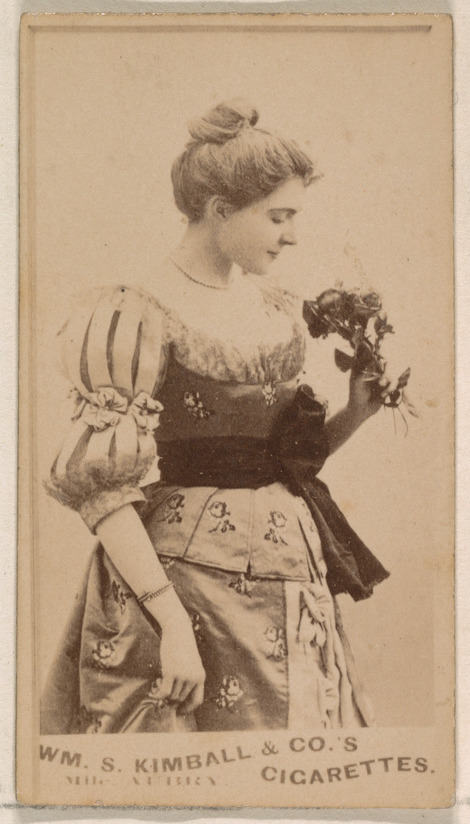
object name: photograph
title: Mlle. Aubry, from the Actresses series (N203) issued by Wm. S. Kimball & Co.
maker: william s. kimball & company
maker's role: publisher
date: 1889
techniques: color lithograph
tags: portraits,women,actresses